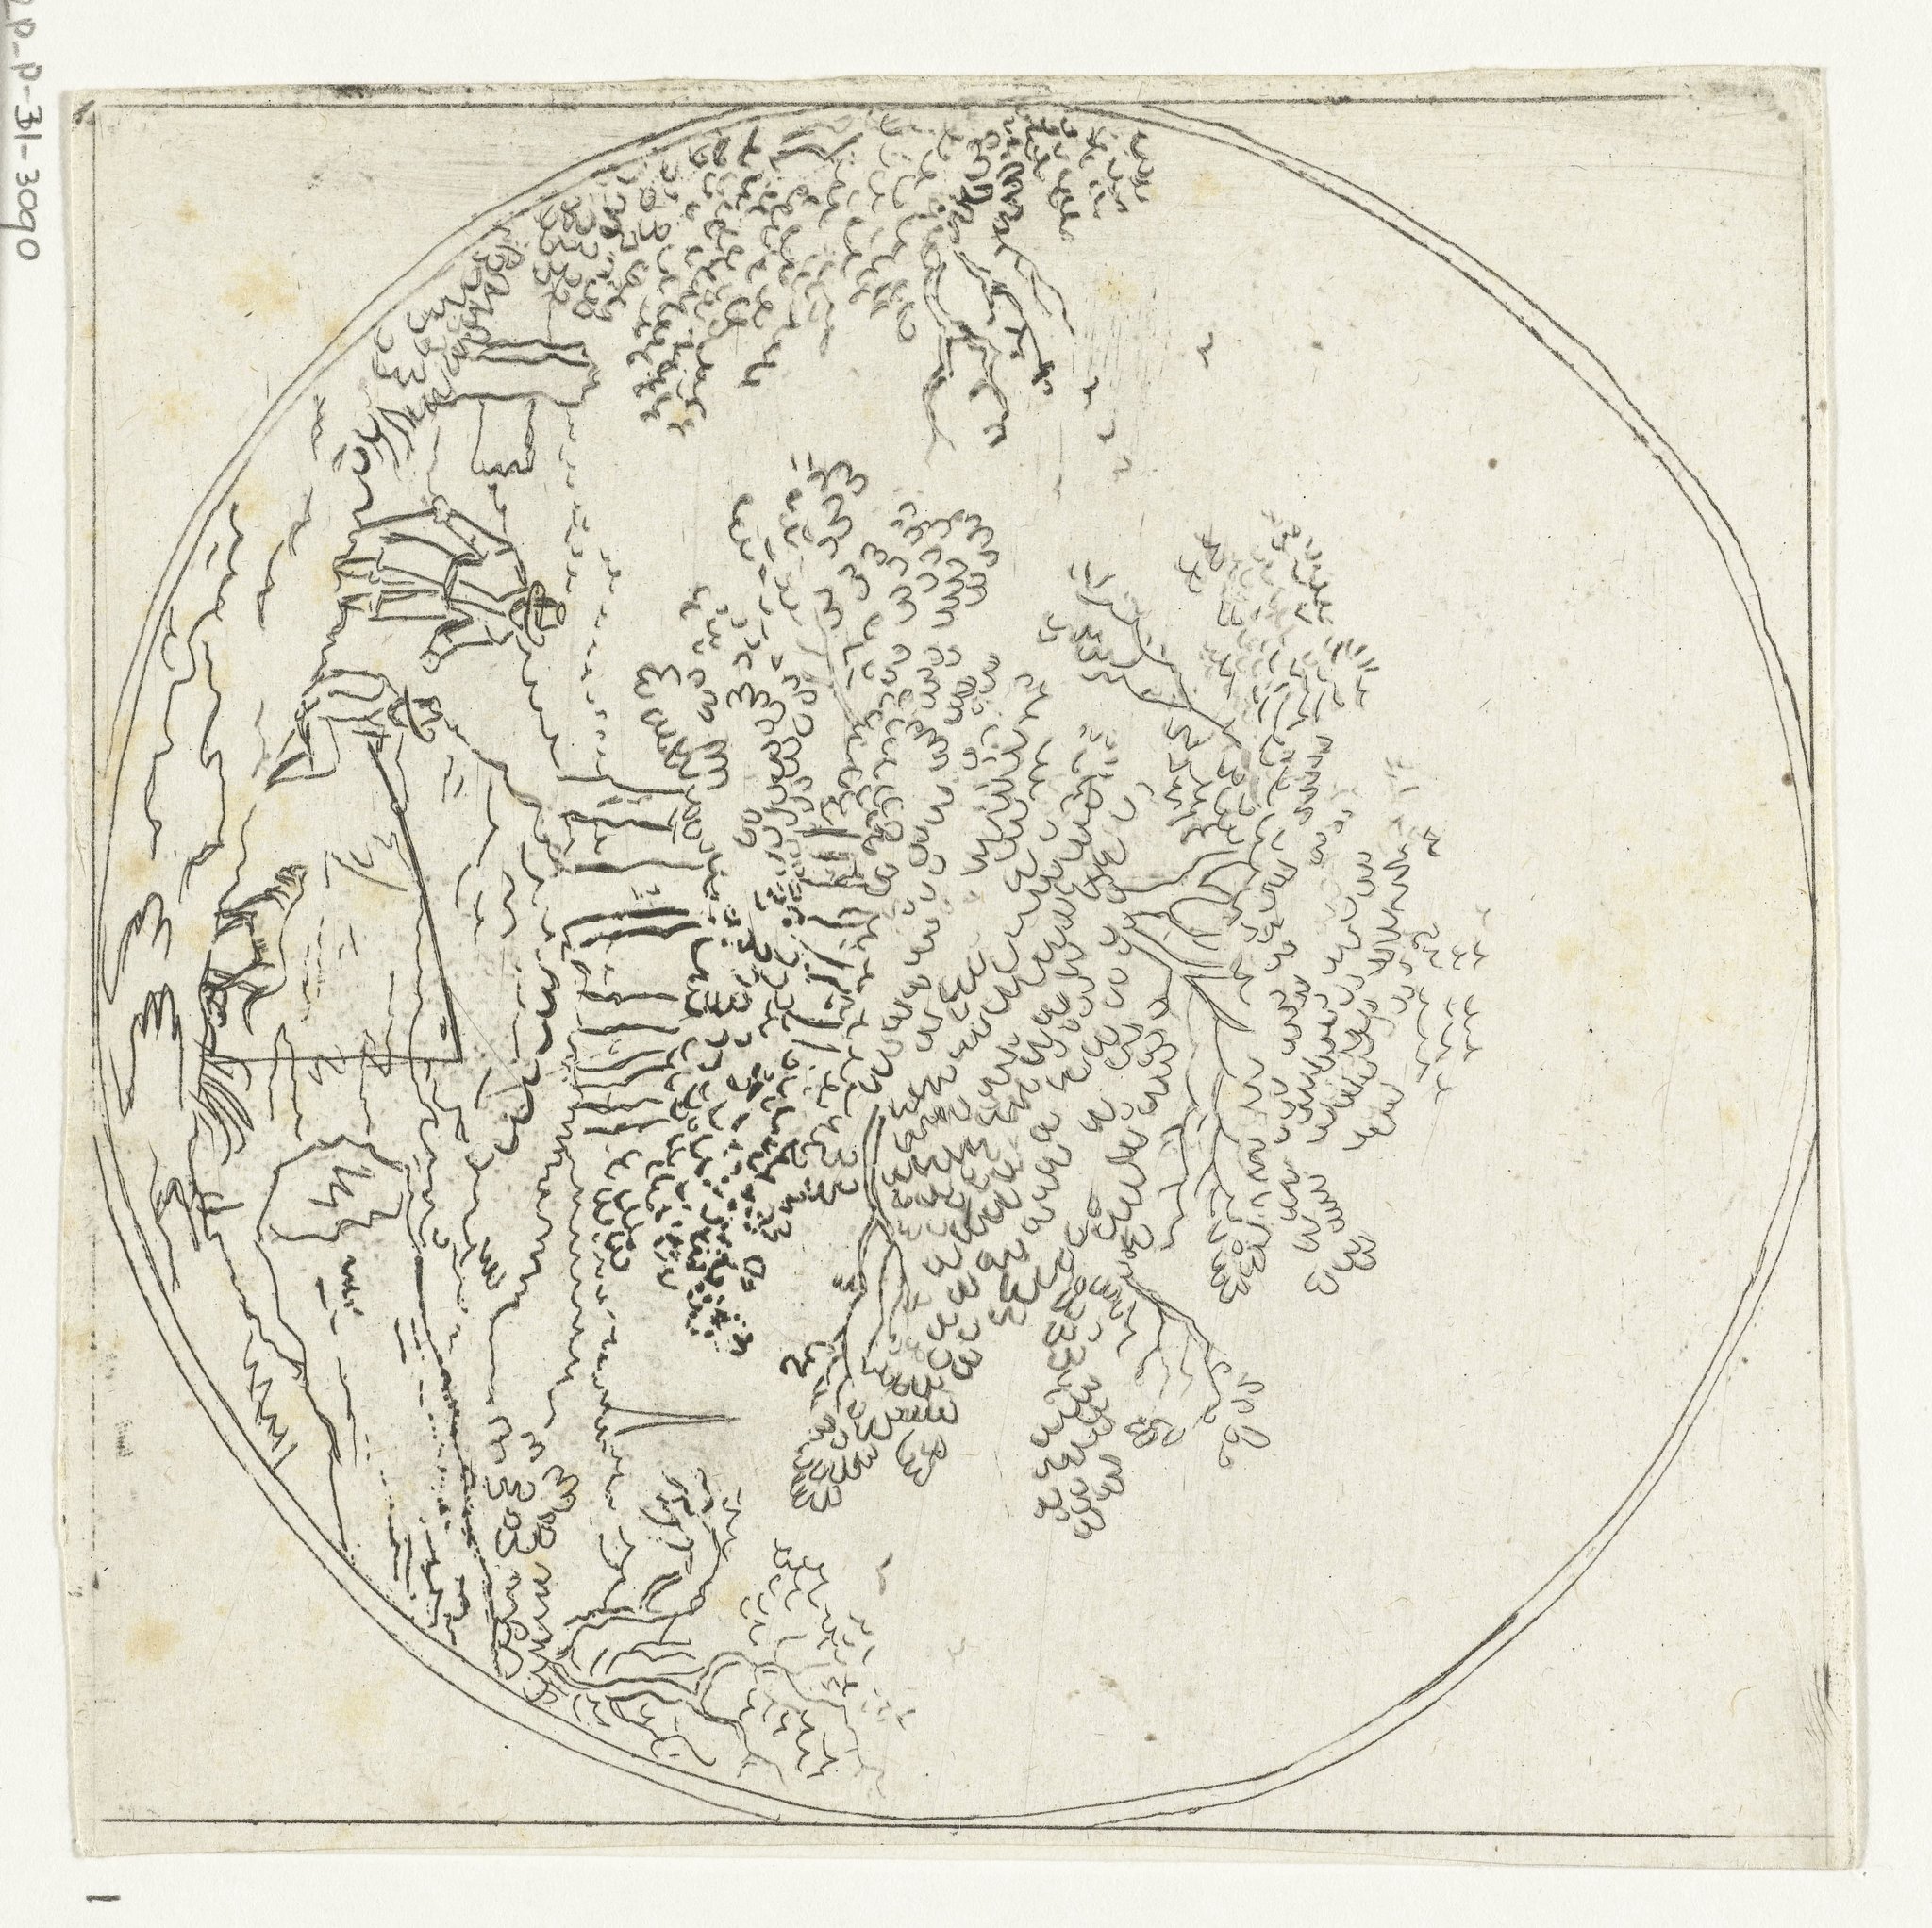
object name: print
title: Landschap met hengelaar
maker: anthonie van den bos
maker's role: draughtsman, print maker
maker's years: 1763-1838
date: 1778-1838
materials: paper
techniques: etching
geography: netherlands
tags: landscapes with waters, waterscapes, seascapes (in the temperate zone), angling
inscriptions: collector's mark: Lugt 2228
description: Een hengelende man zit met zijn hond aan de oever van een rivier. Aan de overkant staat een groep bomen. Een wandelaar maakt een praatje met de hengelaar.